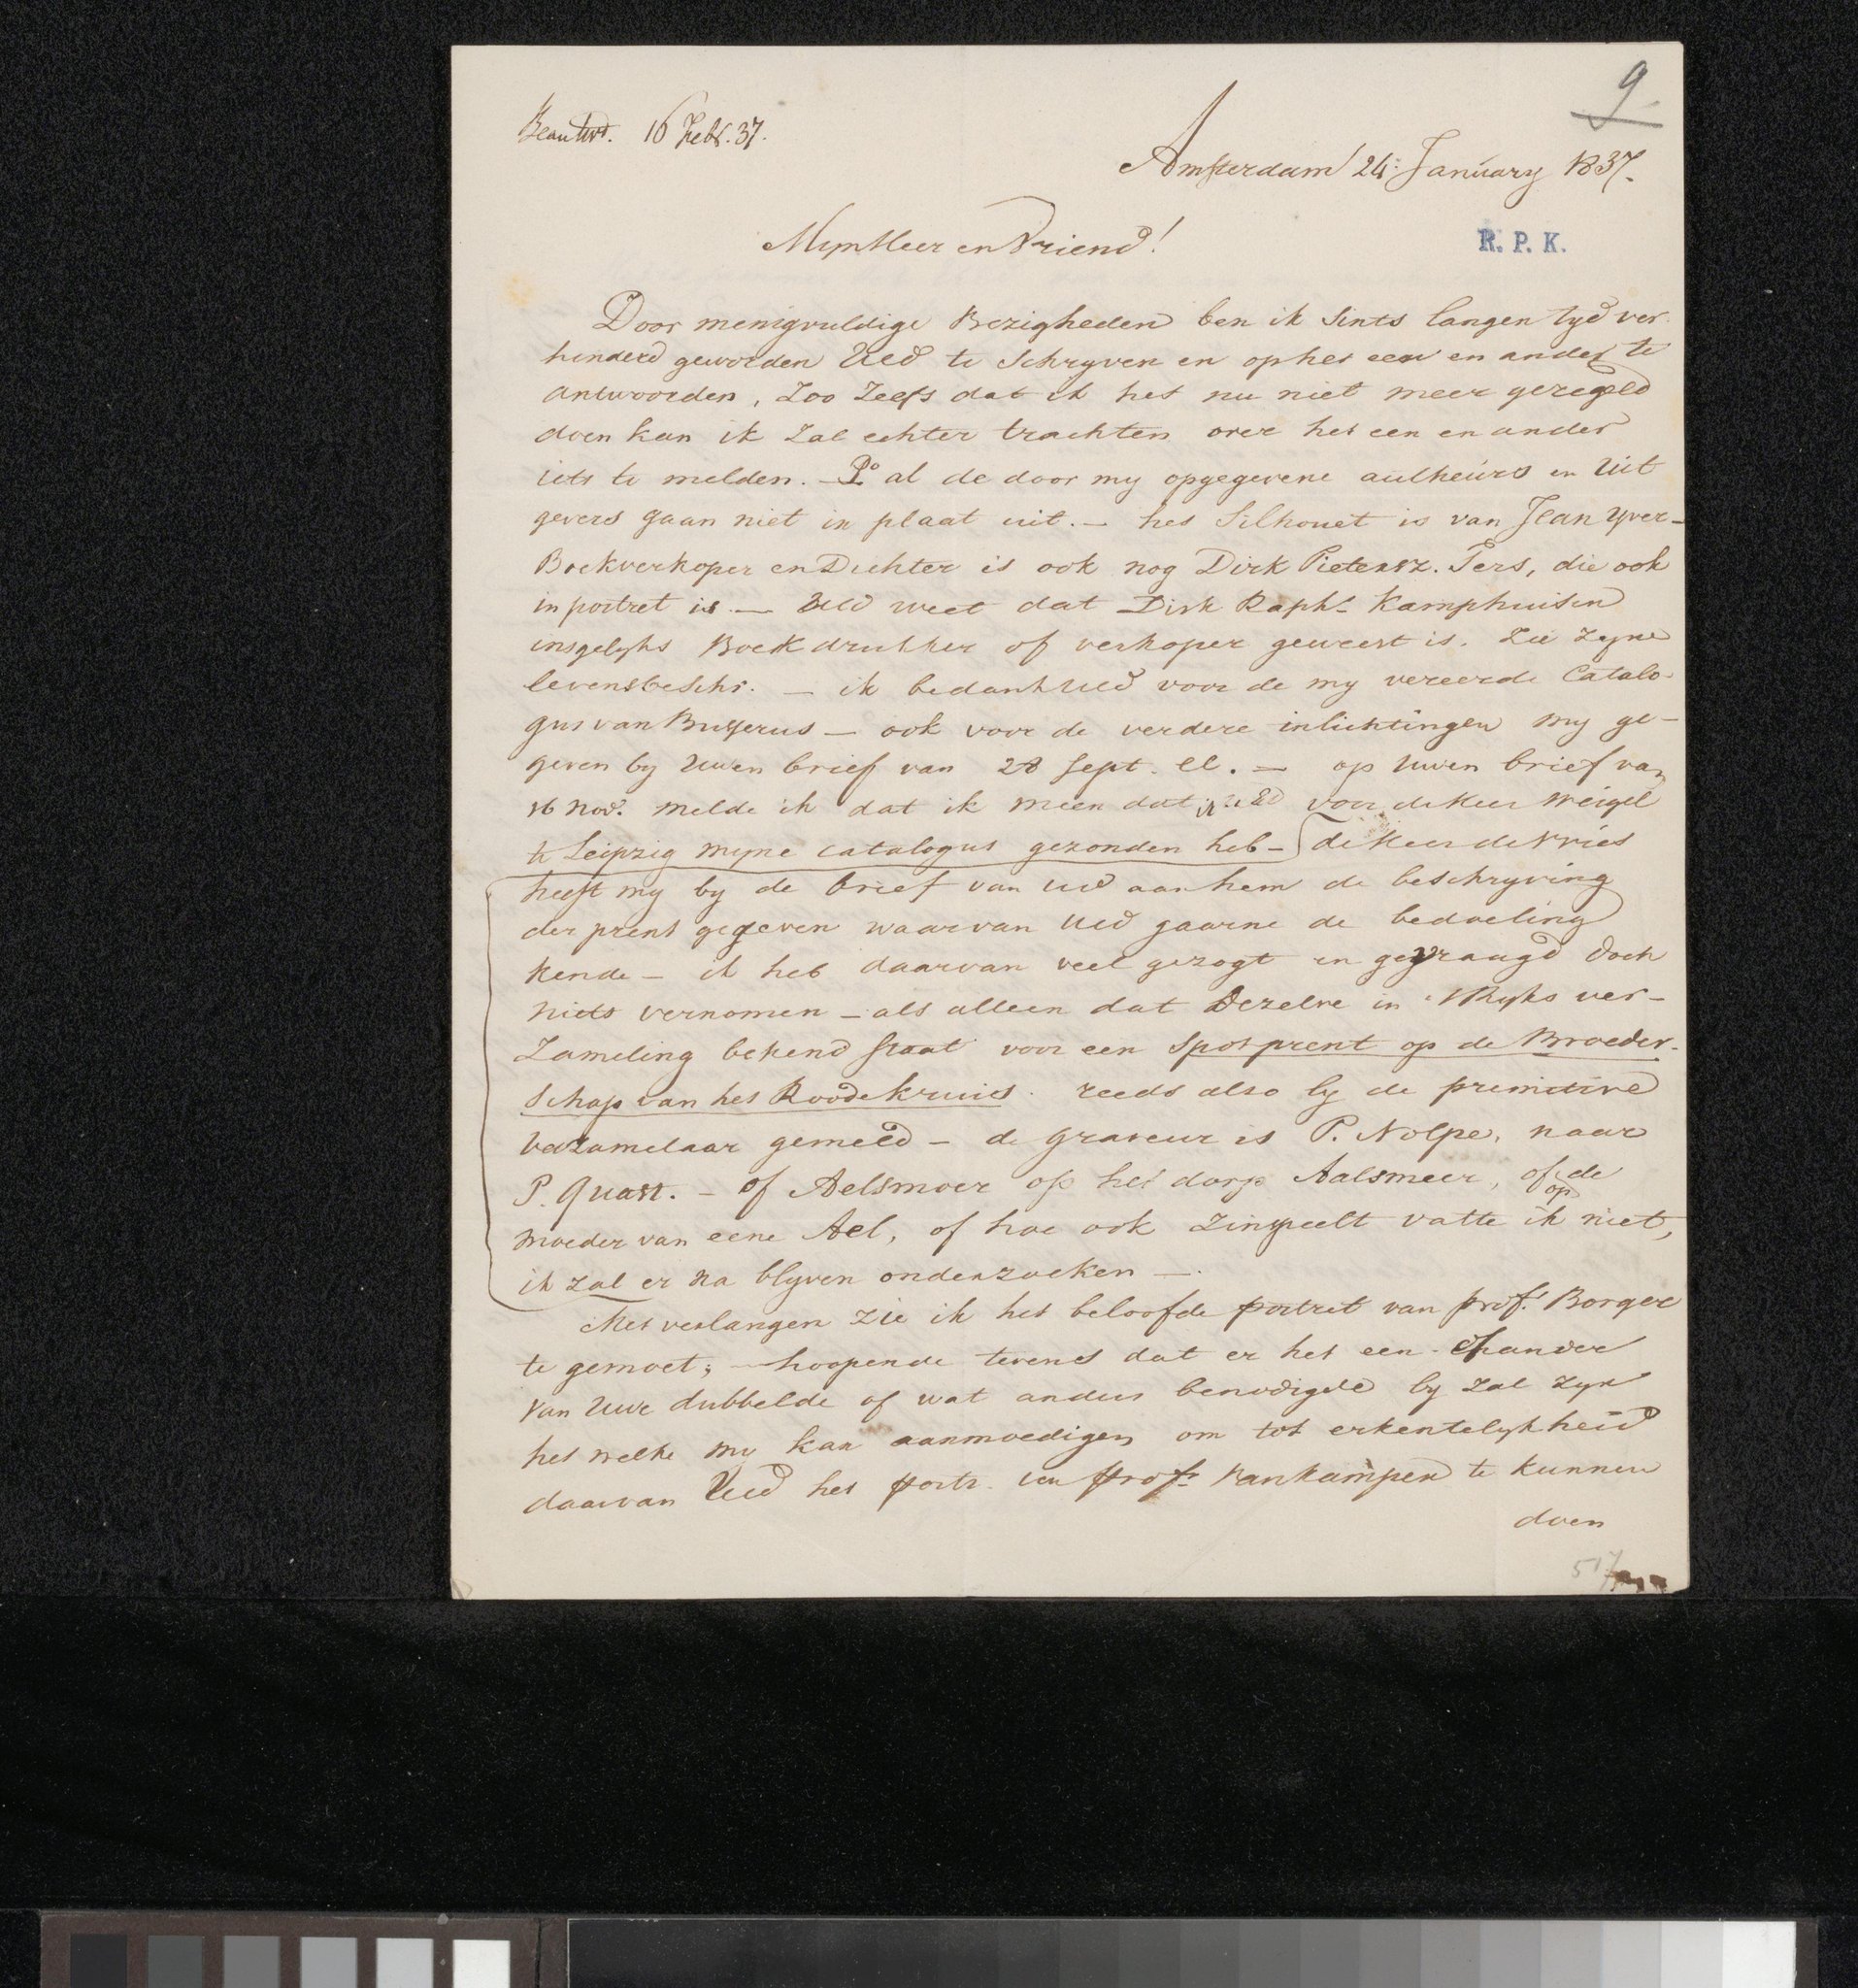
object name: letter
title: Brief aan Johannes Tiberius Bodel Nijenhuis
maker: gerrit lamberts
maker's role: bookseller, draughtsman, print maker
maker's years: 1776-1850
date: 1837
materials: ink, paper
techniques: pen, writing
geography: amsterdam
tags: dirck pietersz. pers, printer, rudolf weigel, pieter nolpe, jan yver, amsterdam, leiden, publisher, johannes tiberius bodel nijenhuis, art trade, art shop, the graphic arts, historical persons (portraits and scenes from the life), money, printed matter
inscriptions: collector's mark: Lugt 2233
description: De prent onder gerelateerd object wordt genoemd in de brief.